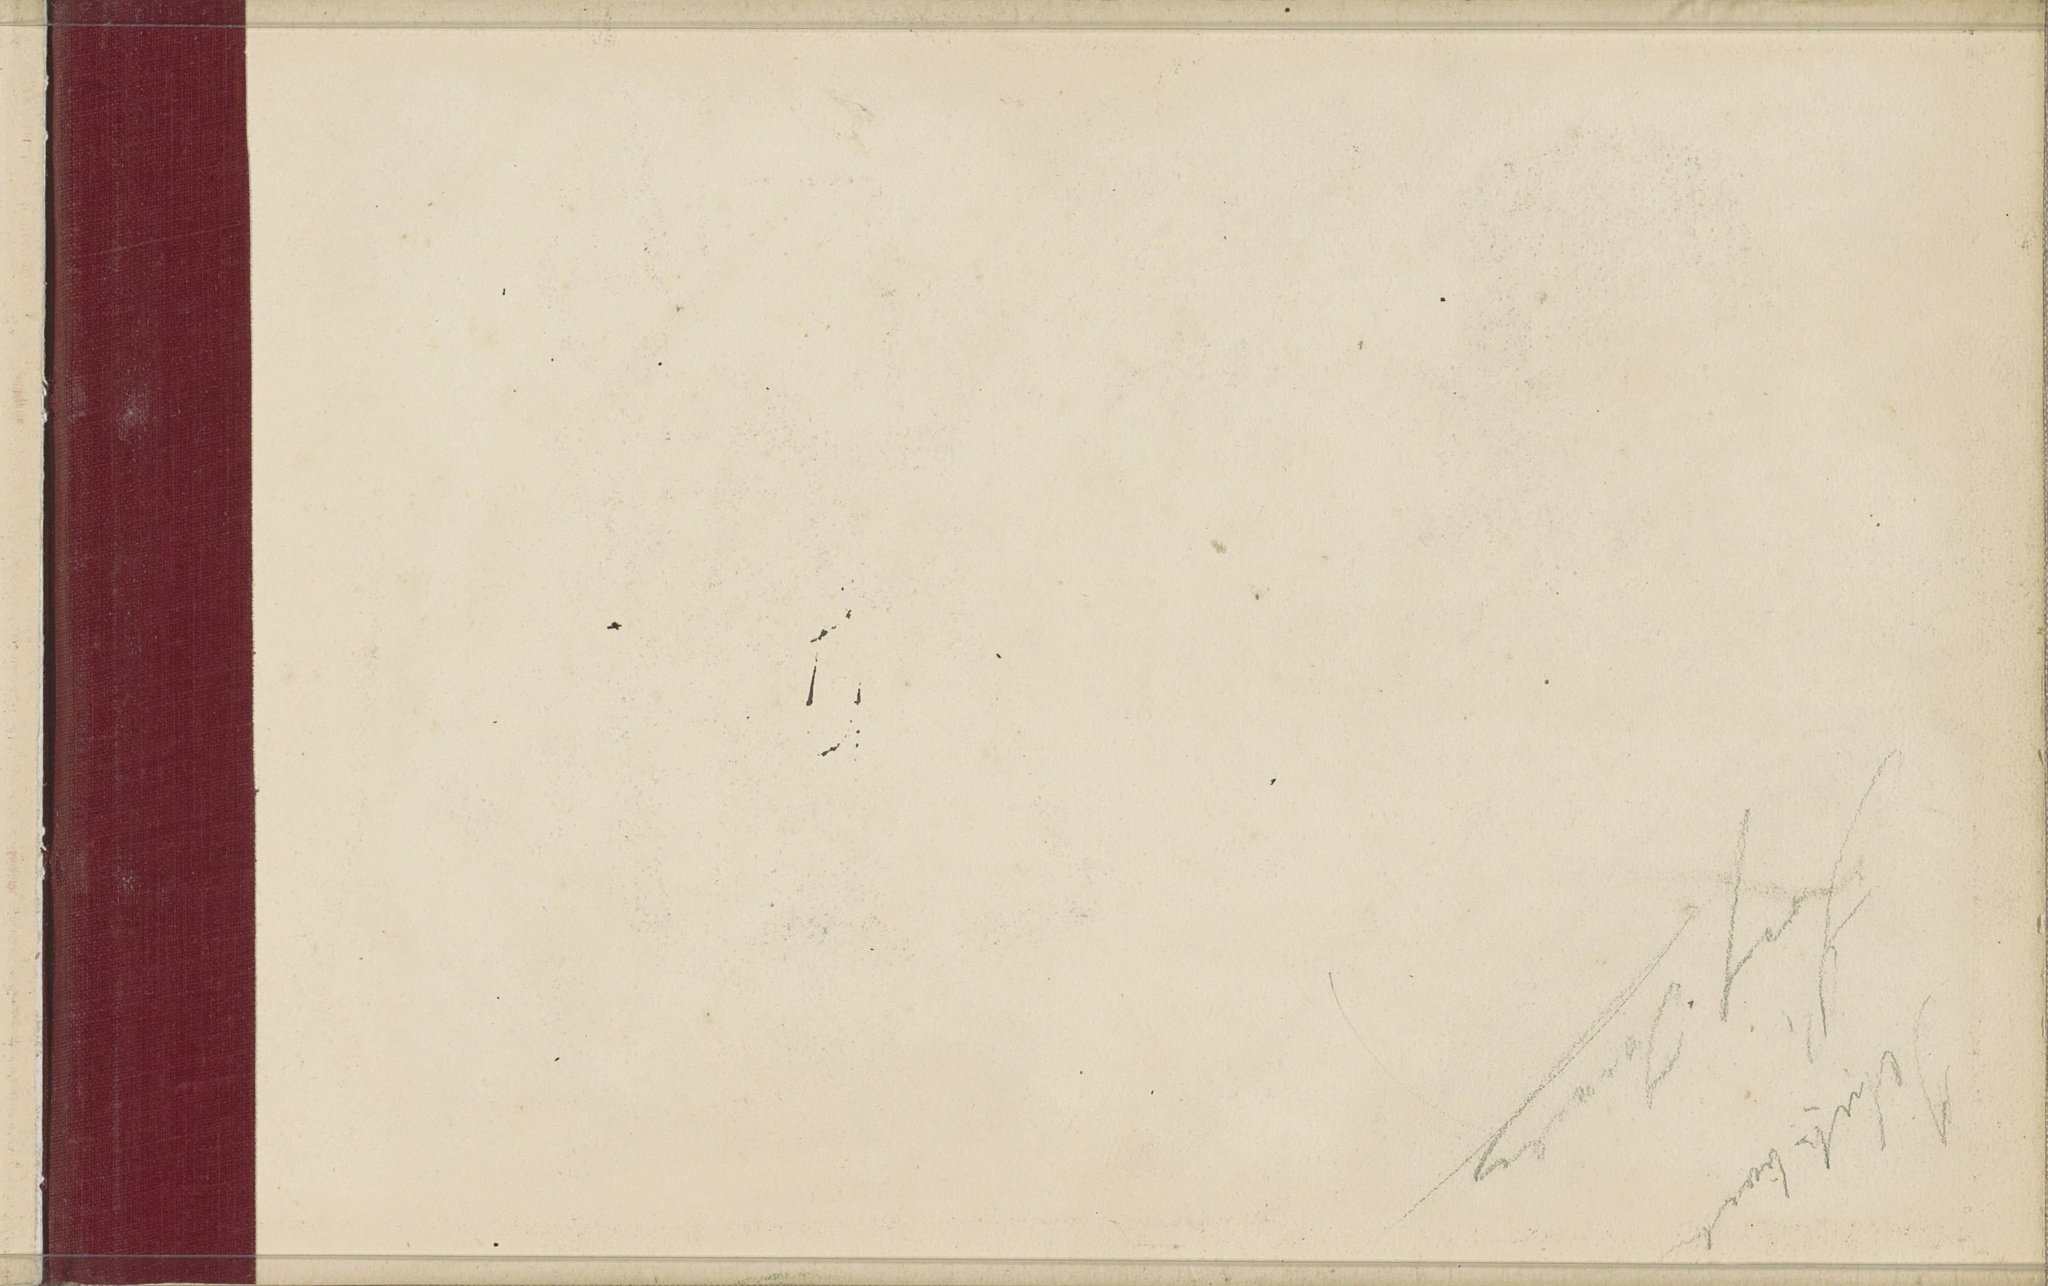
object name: endleaf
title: Signatuur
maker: jozef israëls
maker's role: draughtsman, painter, print maker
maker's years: 1824-1911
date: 1834-1911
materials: paper, pencil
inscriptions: signature: ‘schetsboek/ Jozef Israels’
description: Achterste schutblad uit een schetsboek met 25 bladen.